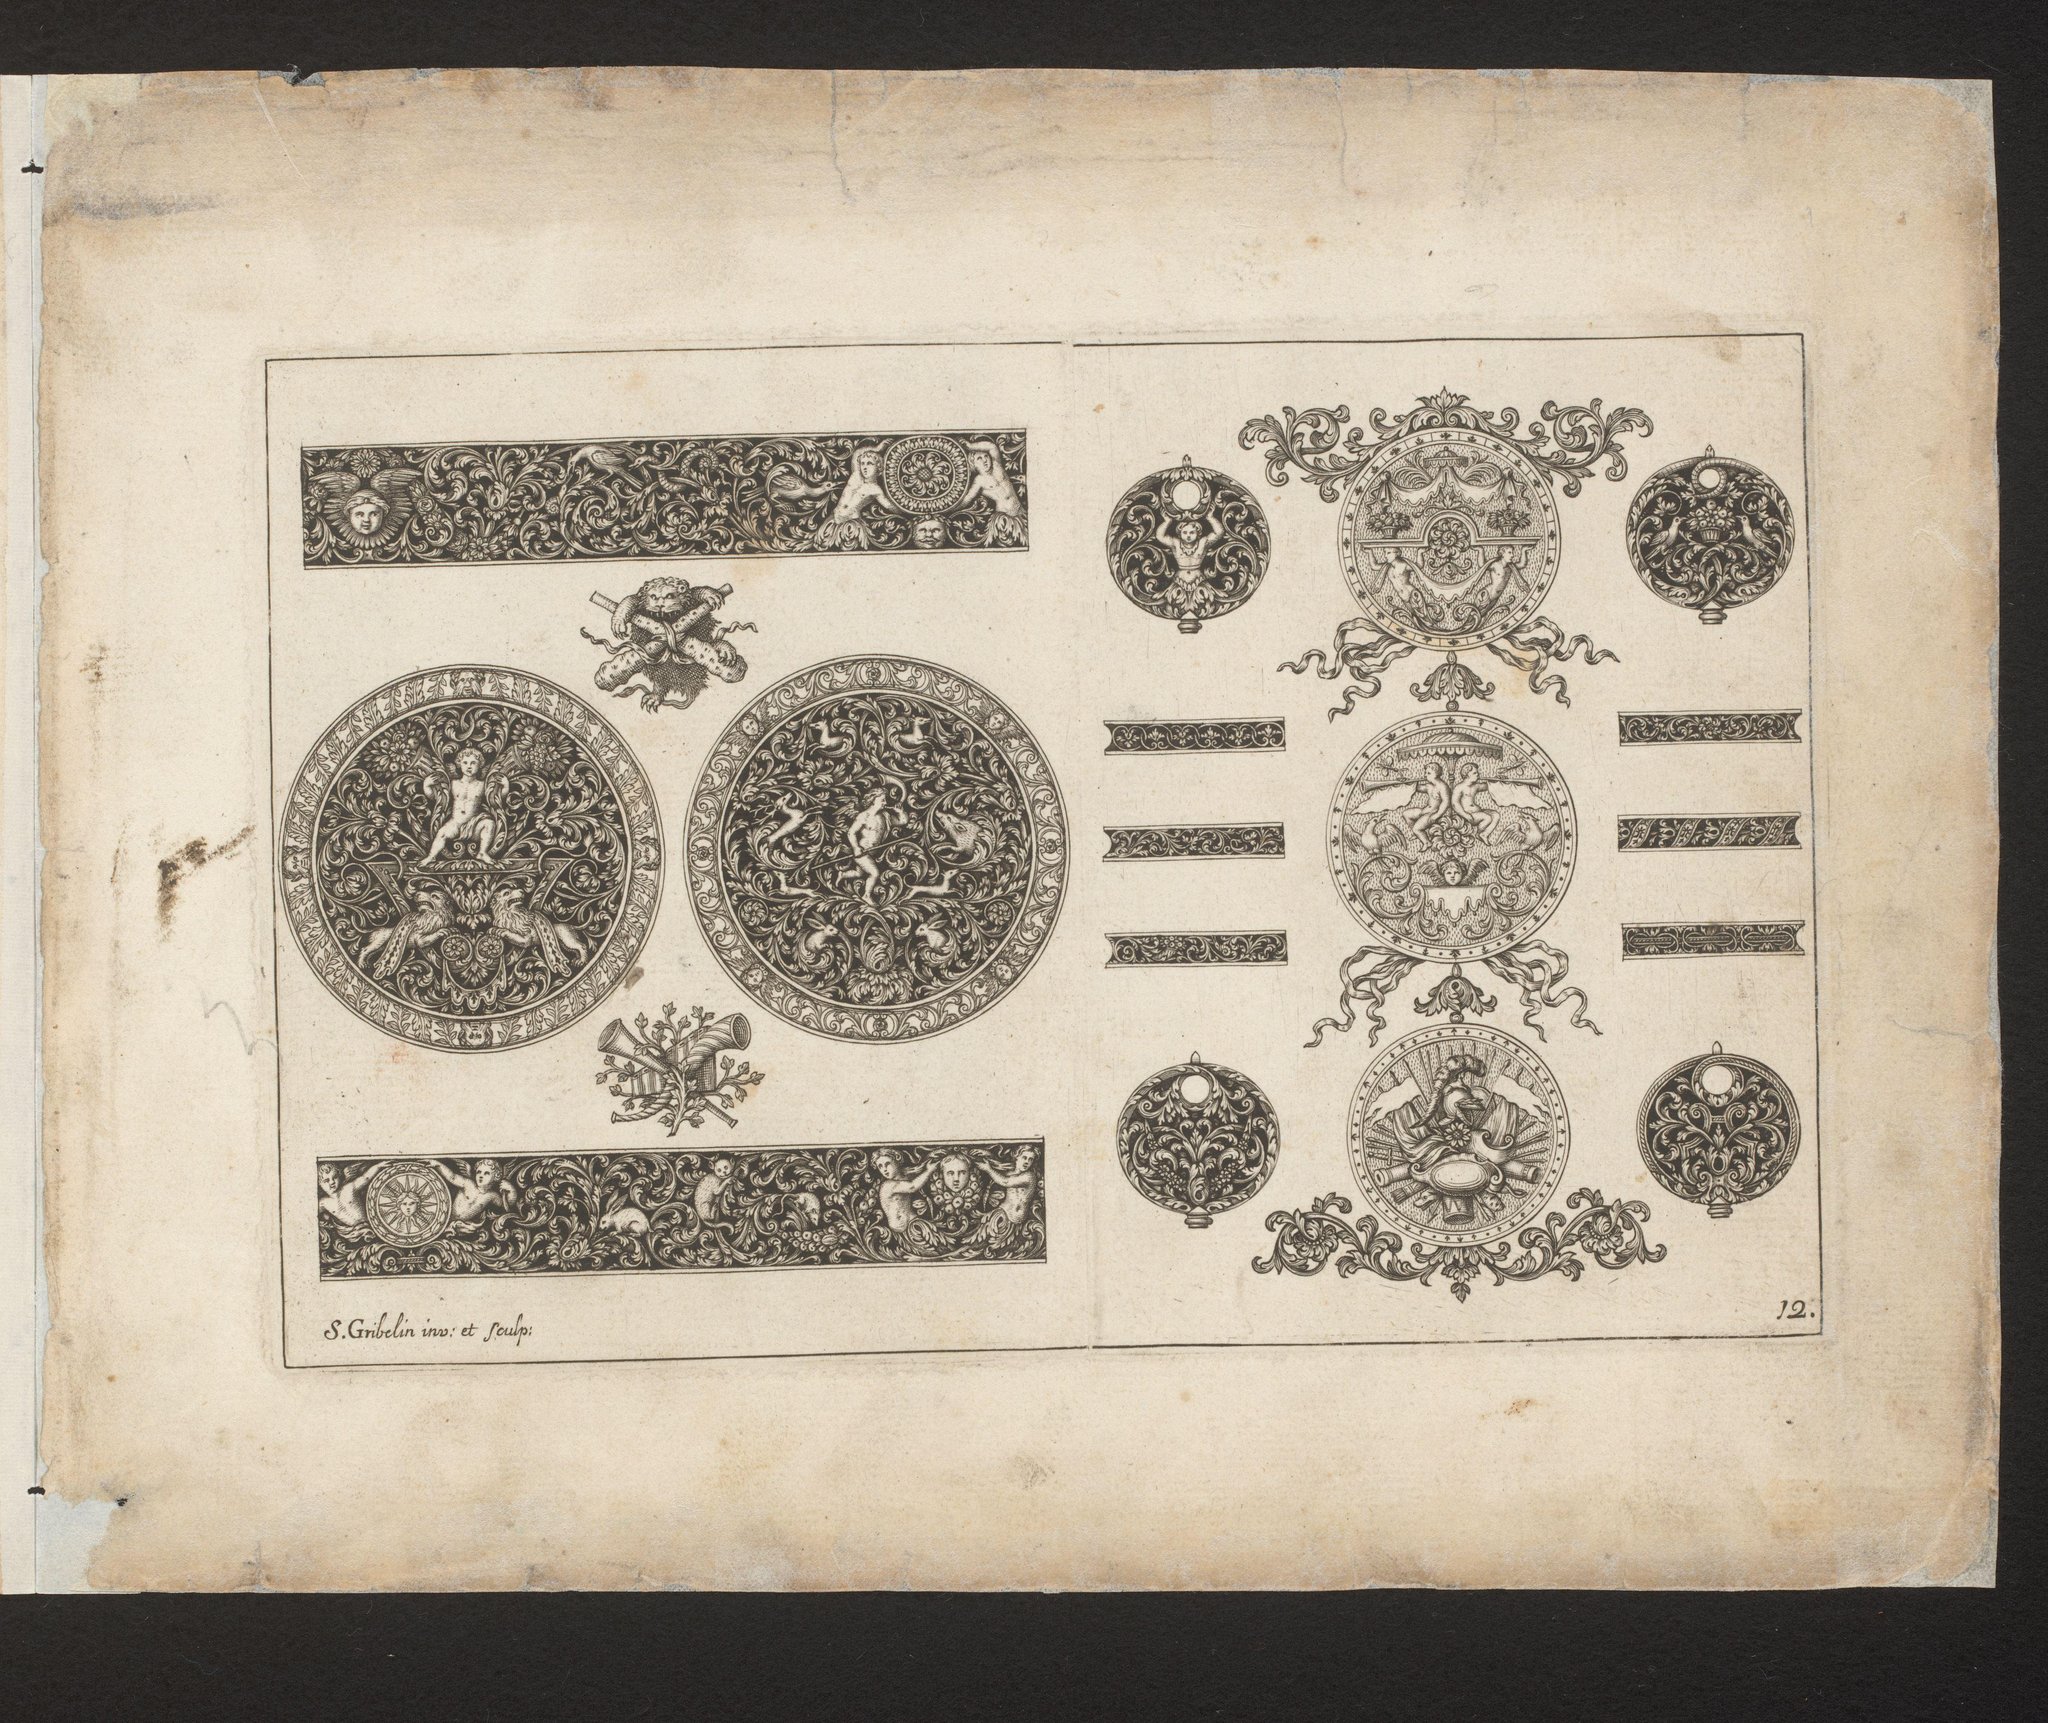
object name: print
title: Boek met ornamentprenten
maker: simon gribelin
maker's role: print maker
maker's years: 1661-1733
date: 1704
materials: paper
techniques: engraving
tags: ornaments ~ art, cupids: 'amores', 'amoretti', 'putti', ornament derived from plant forms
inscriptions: collector's mark: Lugt 2760, collector's mark: Lugt 2228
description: De eerste versie van deze prentserie is uitgegeven in 1682 met de titel 'A Book of Severall Ornaments'.